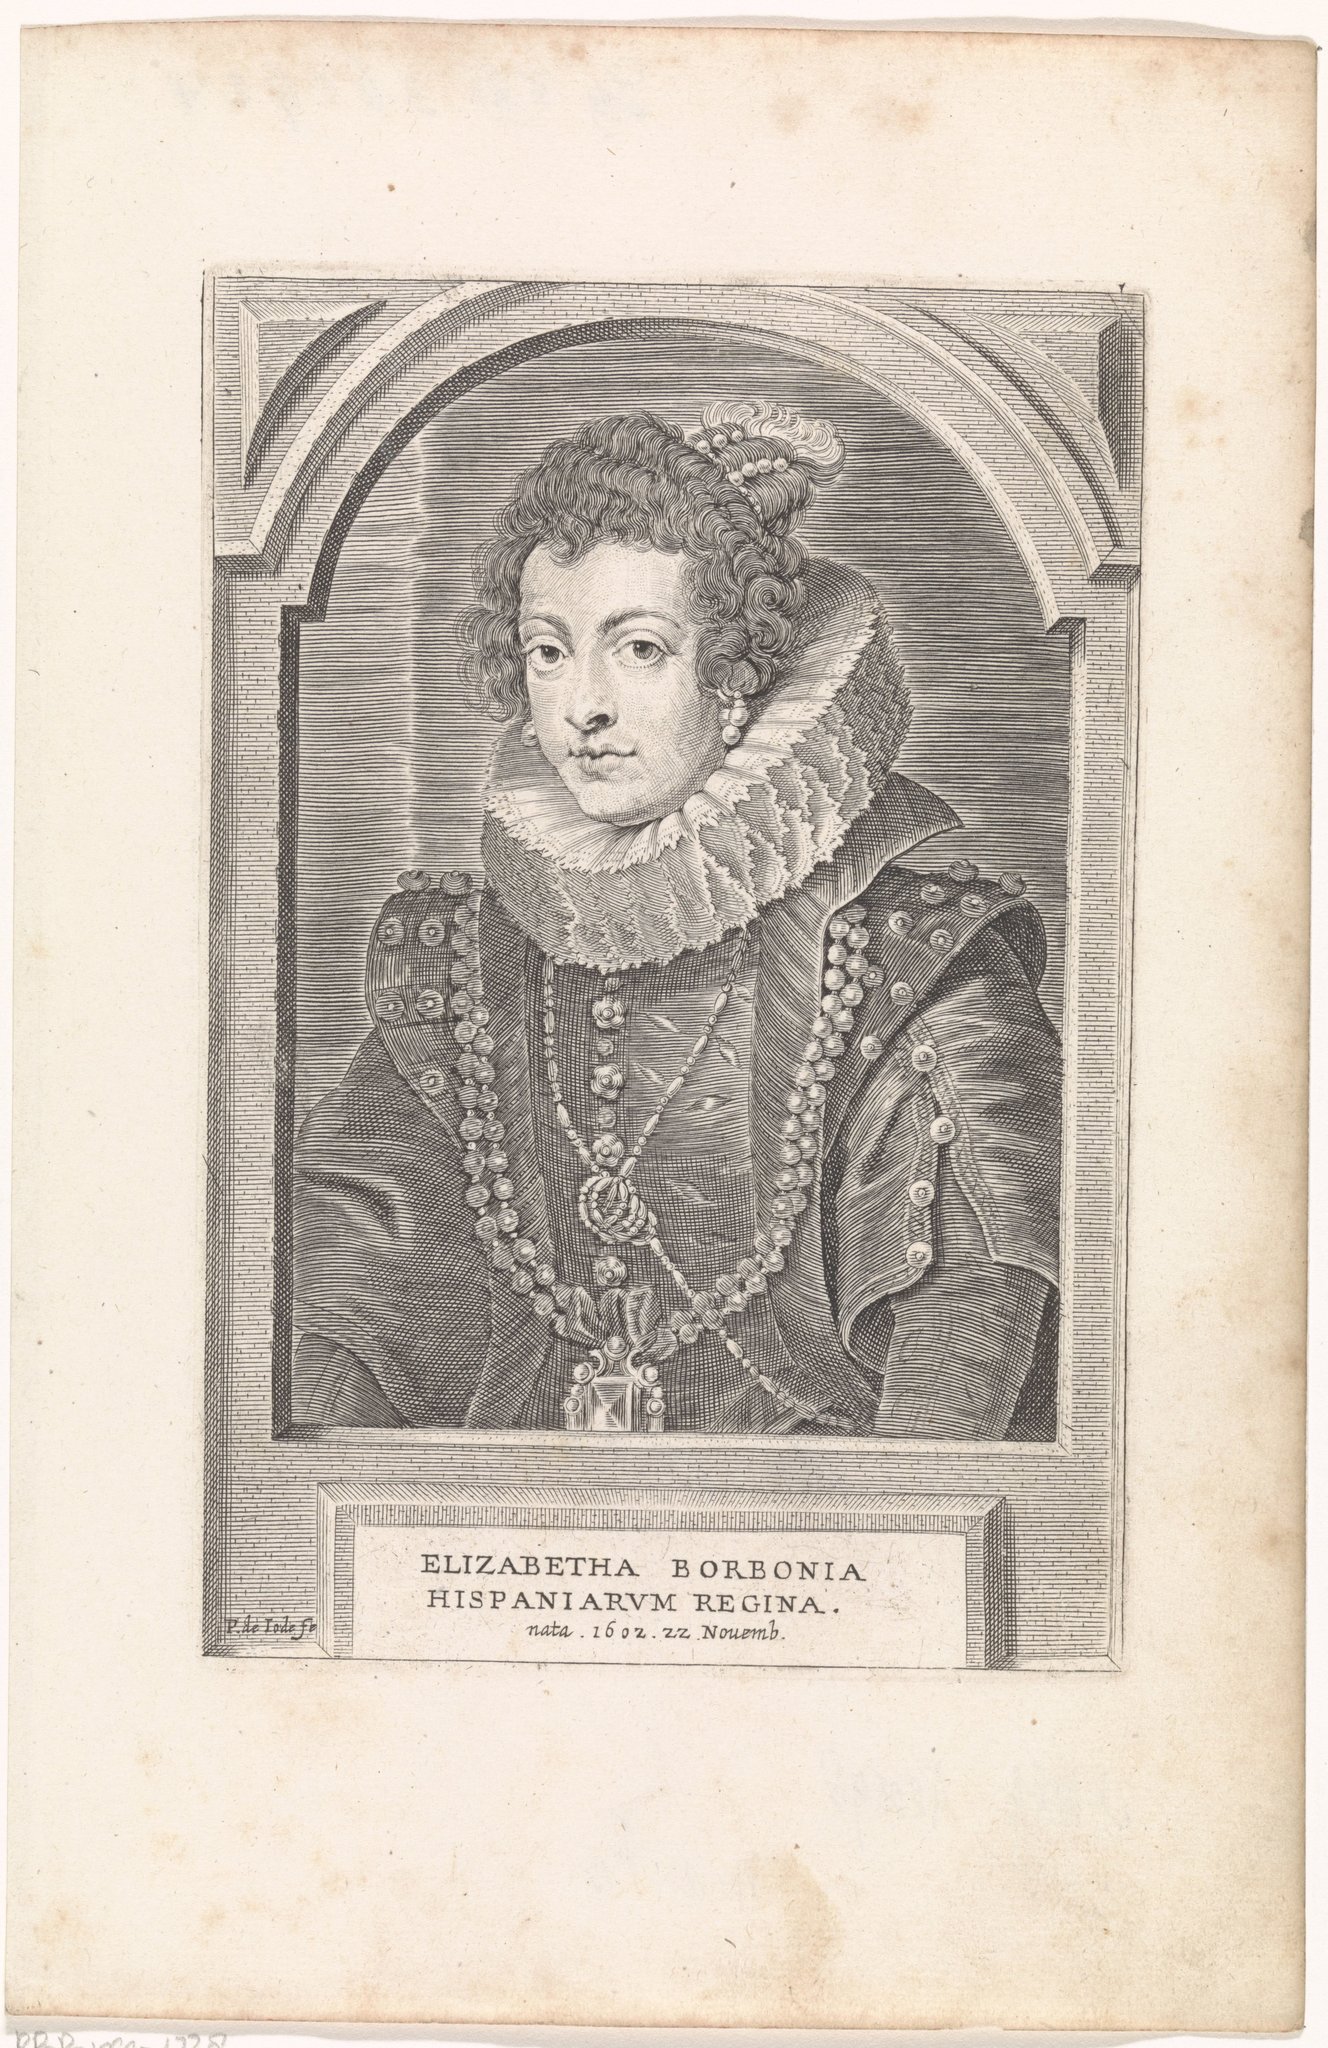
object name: print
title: Theatrum pontificum, imperatorum, regum, ducum, principum, etc.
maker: pieter de jode (ii)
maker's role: draughtsman, print maker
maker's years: 1606-1674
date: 1628-1670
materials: paper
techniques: engraving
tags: elisabeth of france (queen of spain and portugal)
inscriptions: collector's mark: Lugt 2760, collector's mark: Lugt 2228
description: Busteportret van Elisabeth van Bourbon, in rijk versierde japon. Het portret is gevat in een boogvormige omlijsting. In een kader een onderschrift in het Latijn.